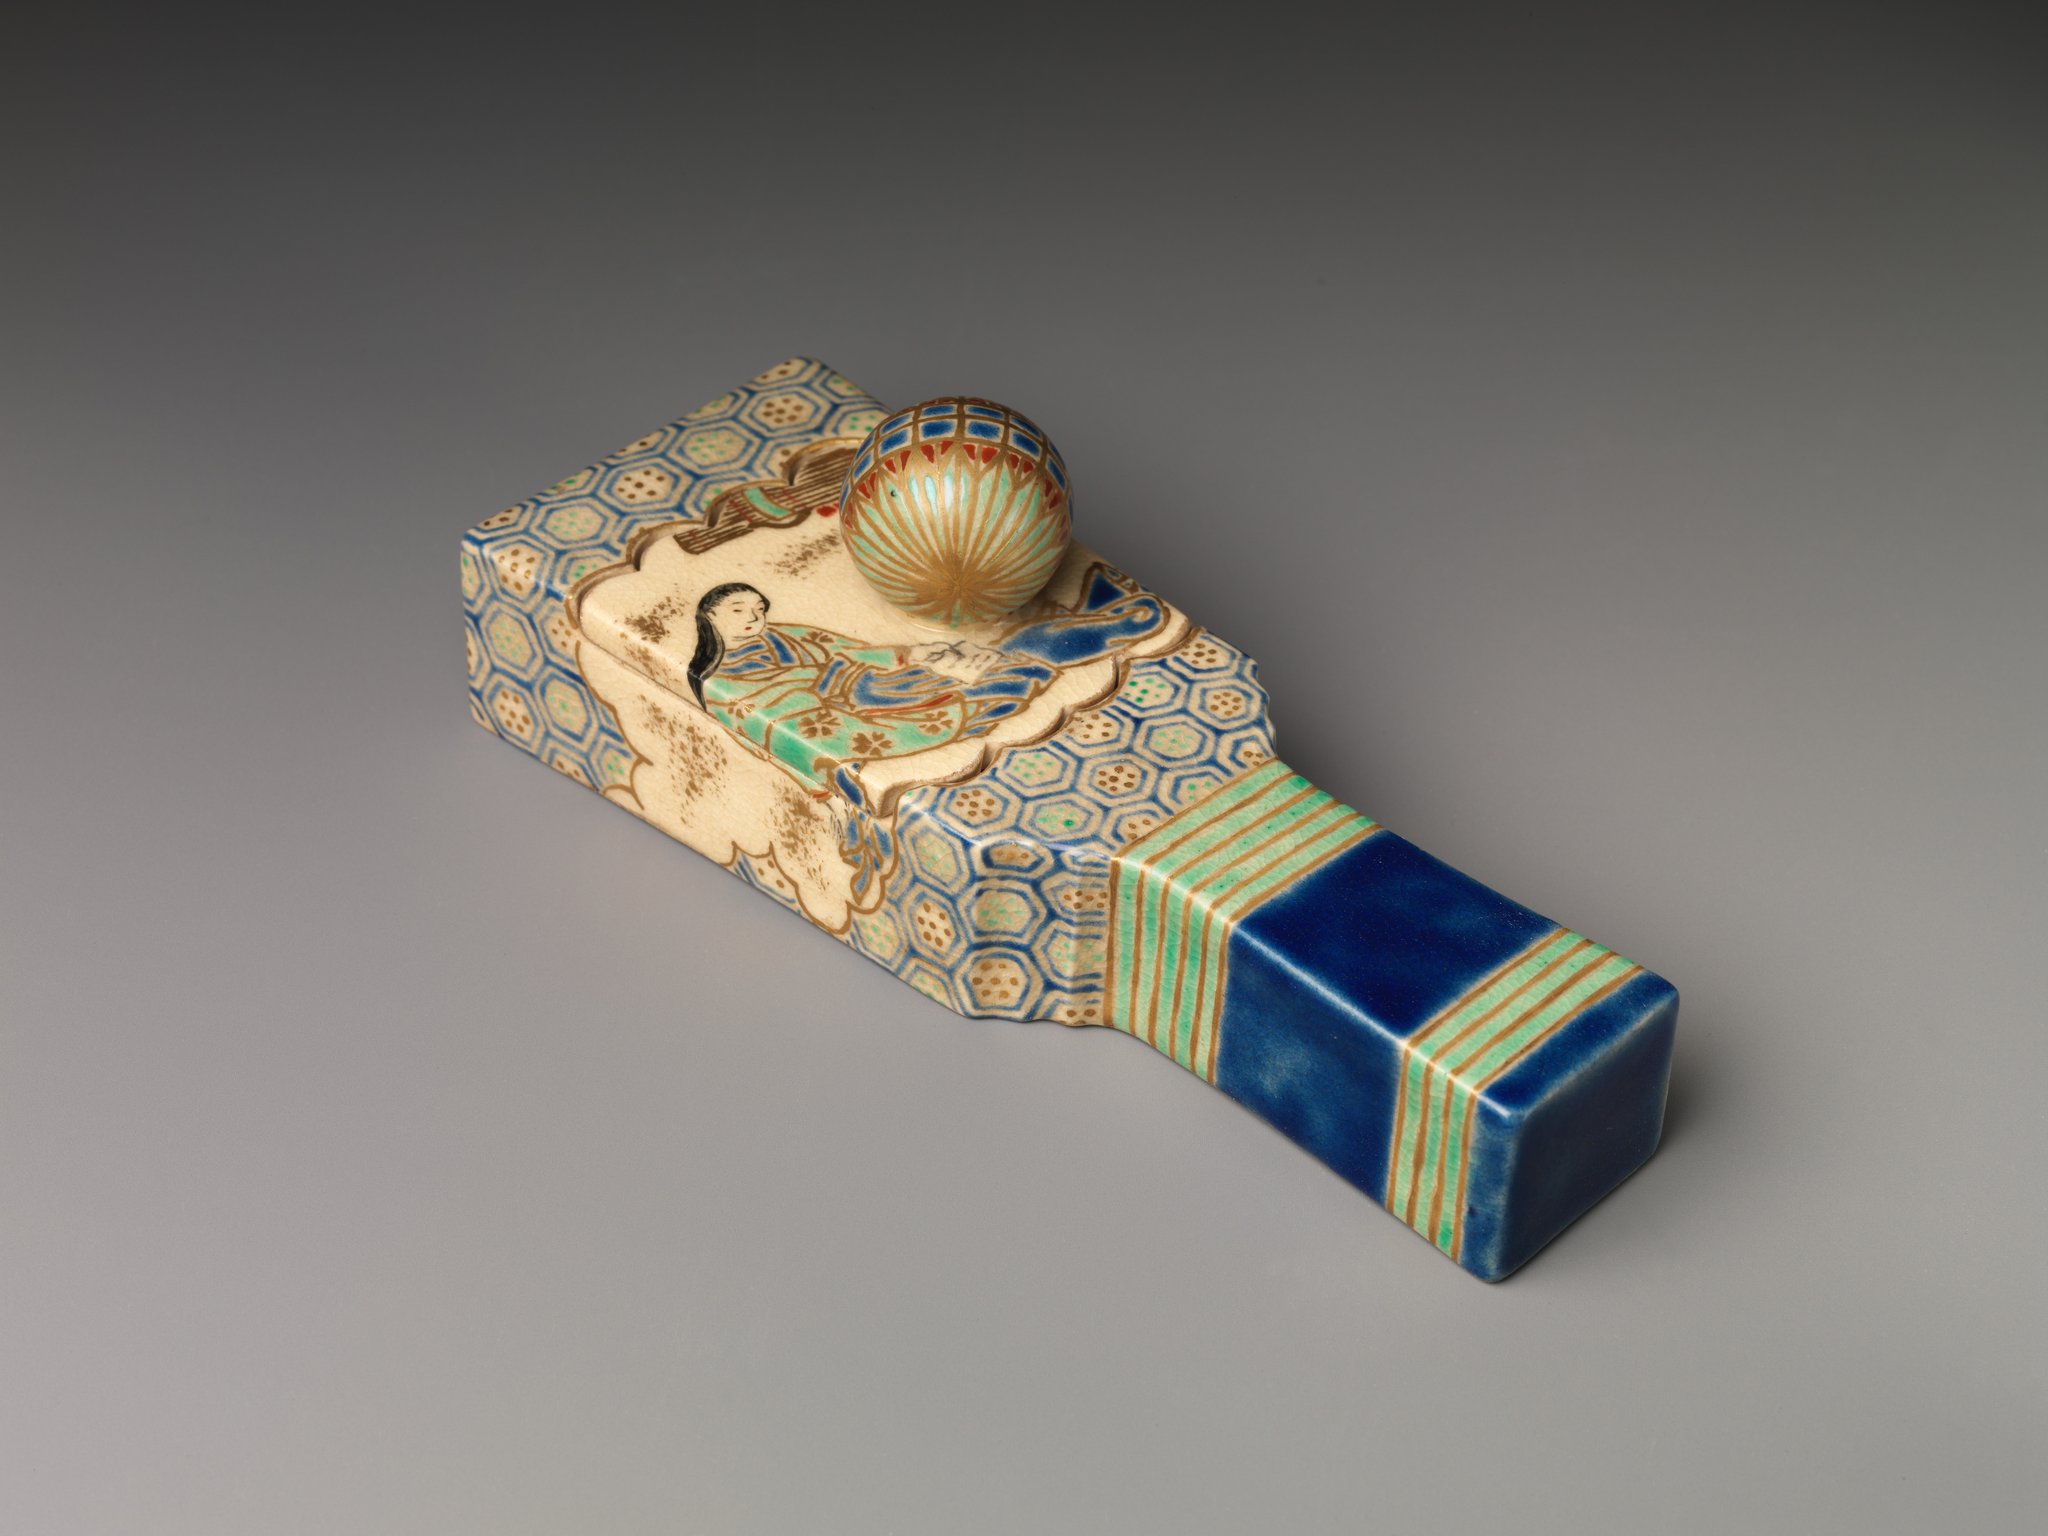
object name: incense container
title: Incense container with lid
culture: japanese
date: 1801-1900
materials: enamel, stoneware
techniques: polychrome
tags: women